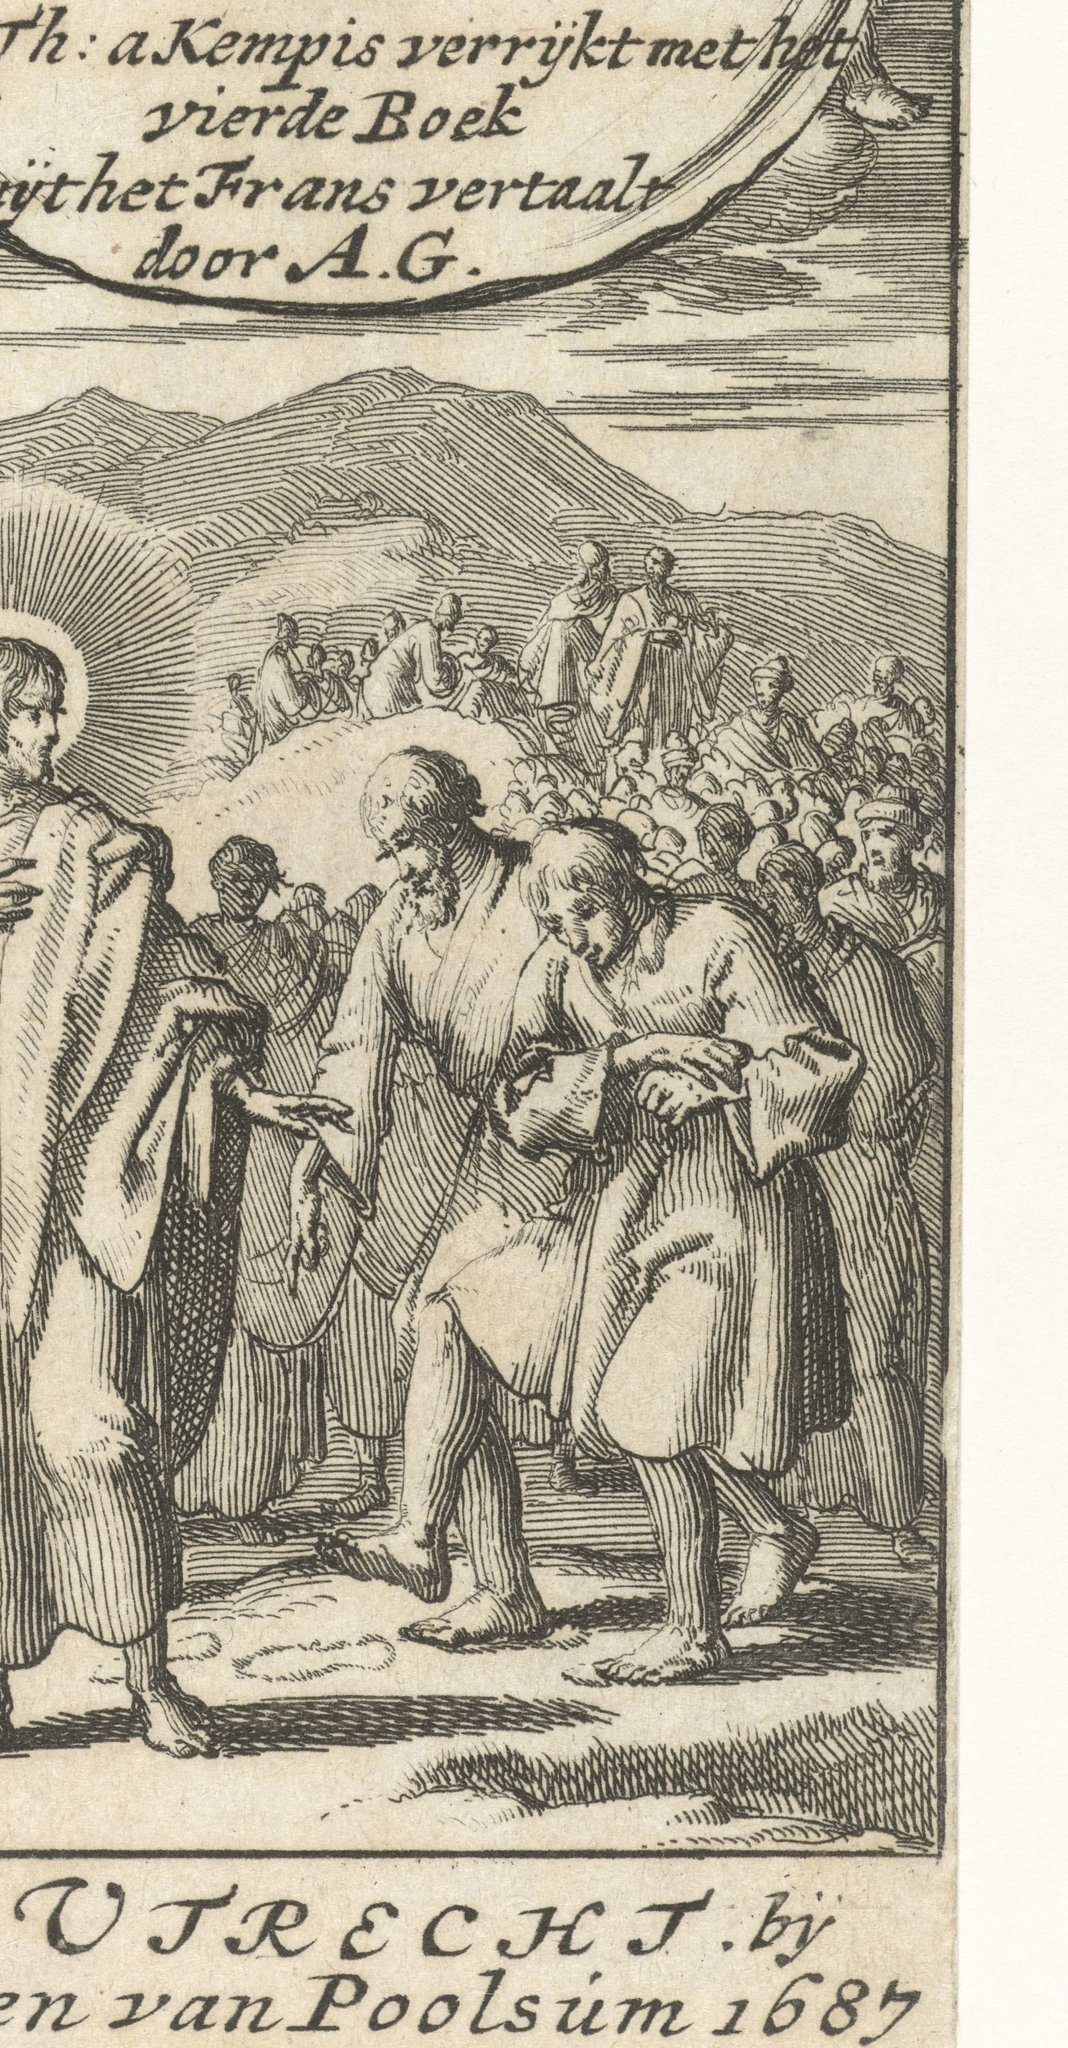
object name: print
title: Christus gevolgd door figuren die in zijn voetafdrukken stappen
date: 1687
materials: paper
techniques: etching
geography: amsterdam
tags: christ as adult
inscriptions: collector's mark: Lugt 2228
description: Titelpagina voor: Kempis, Thomas à. Navolginge Christi. Utrecht: Jurriaen van Poolsum, 1687.